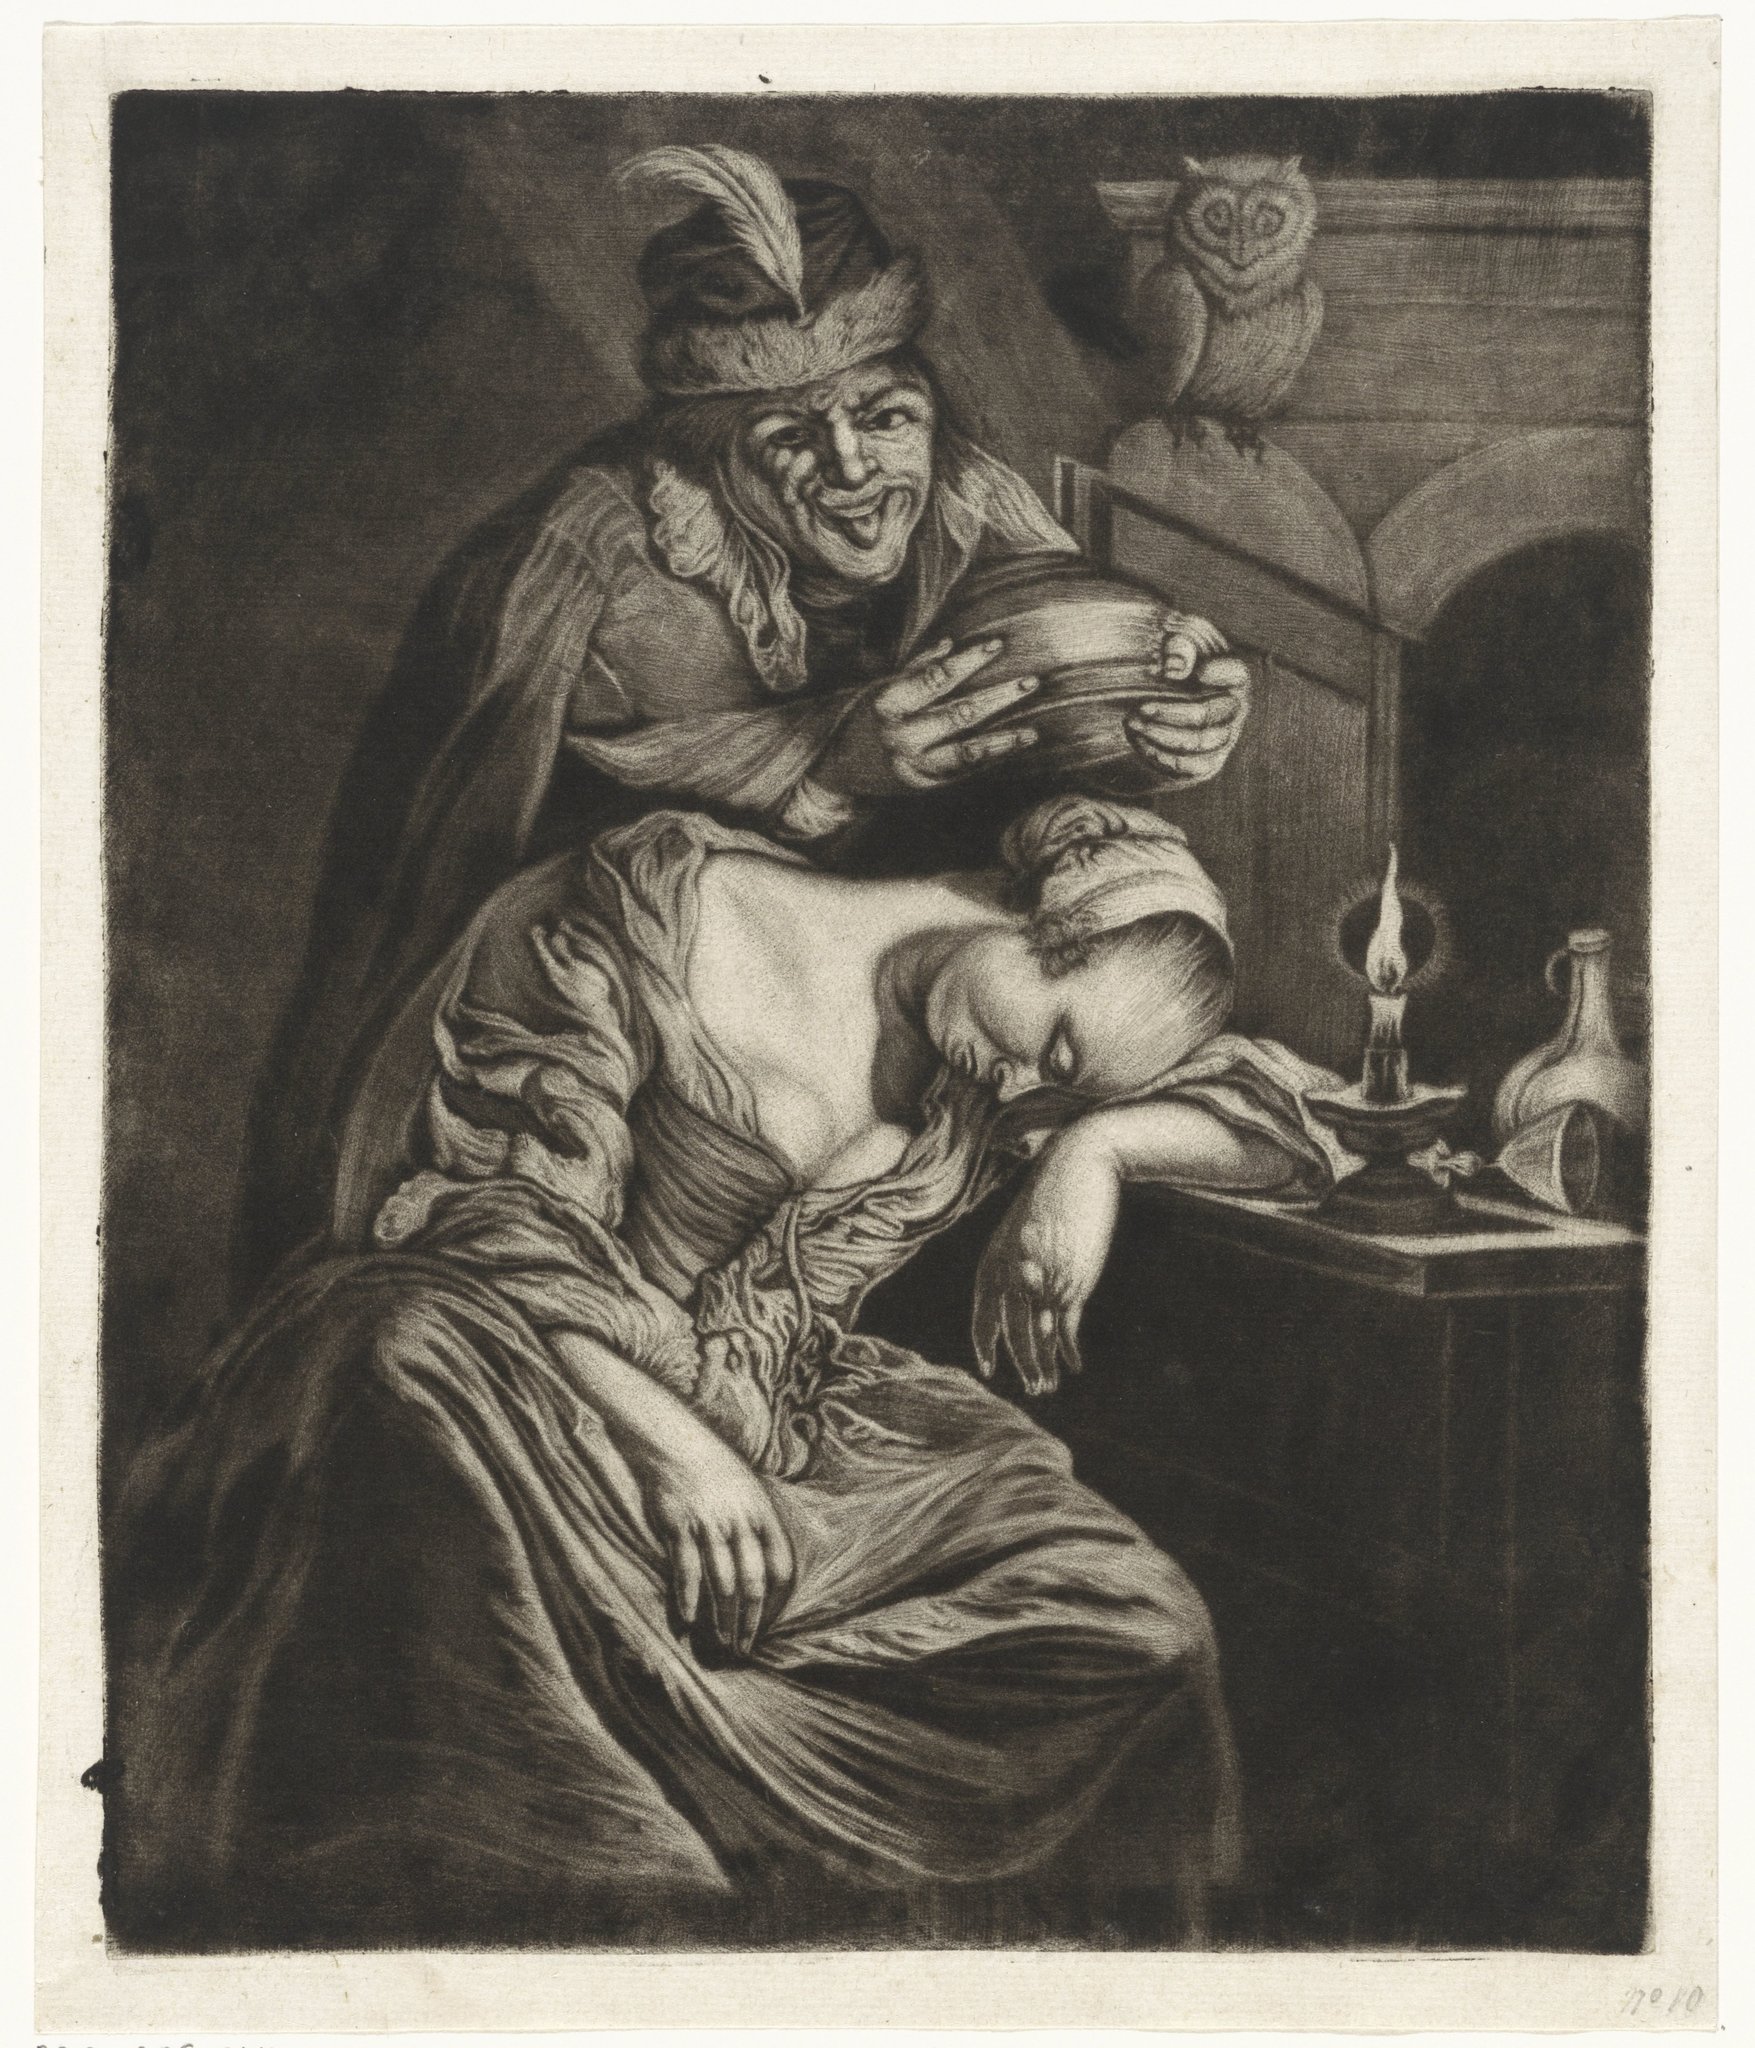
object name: print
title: De wijn is een spotter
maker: jacob hoolaart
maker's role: print maker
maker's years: 1713-1789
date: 1723-1789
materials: paper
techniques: mezzotint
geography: dordrecht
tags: proverbs, sayings, etc., candle, drunkenness, chamber-pot, 'wine is a mocker ...' ~ drunken brawl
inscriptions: collector's mark: Lugt 2228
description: Een nar-achtige figuur staat op het punt om een slapende vrouw een pispot op het hoofd te zetten. Hij steekt zijn tong uit. Op de tafel, waar de vrouw haar hoofd op te rusten heeft gelegd, ligt een omgevallen wijnglas. Op de deur van het venster zit een uil.